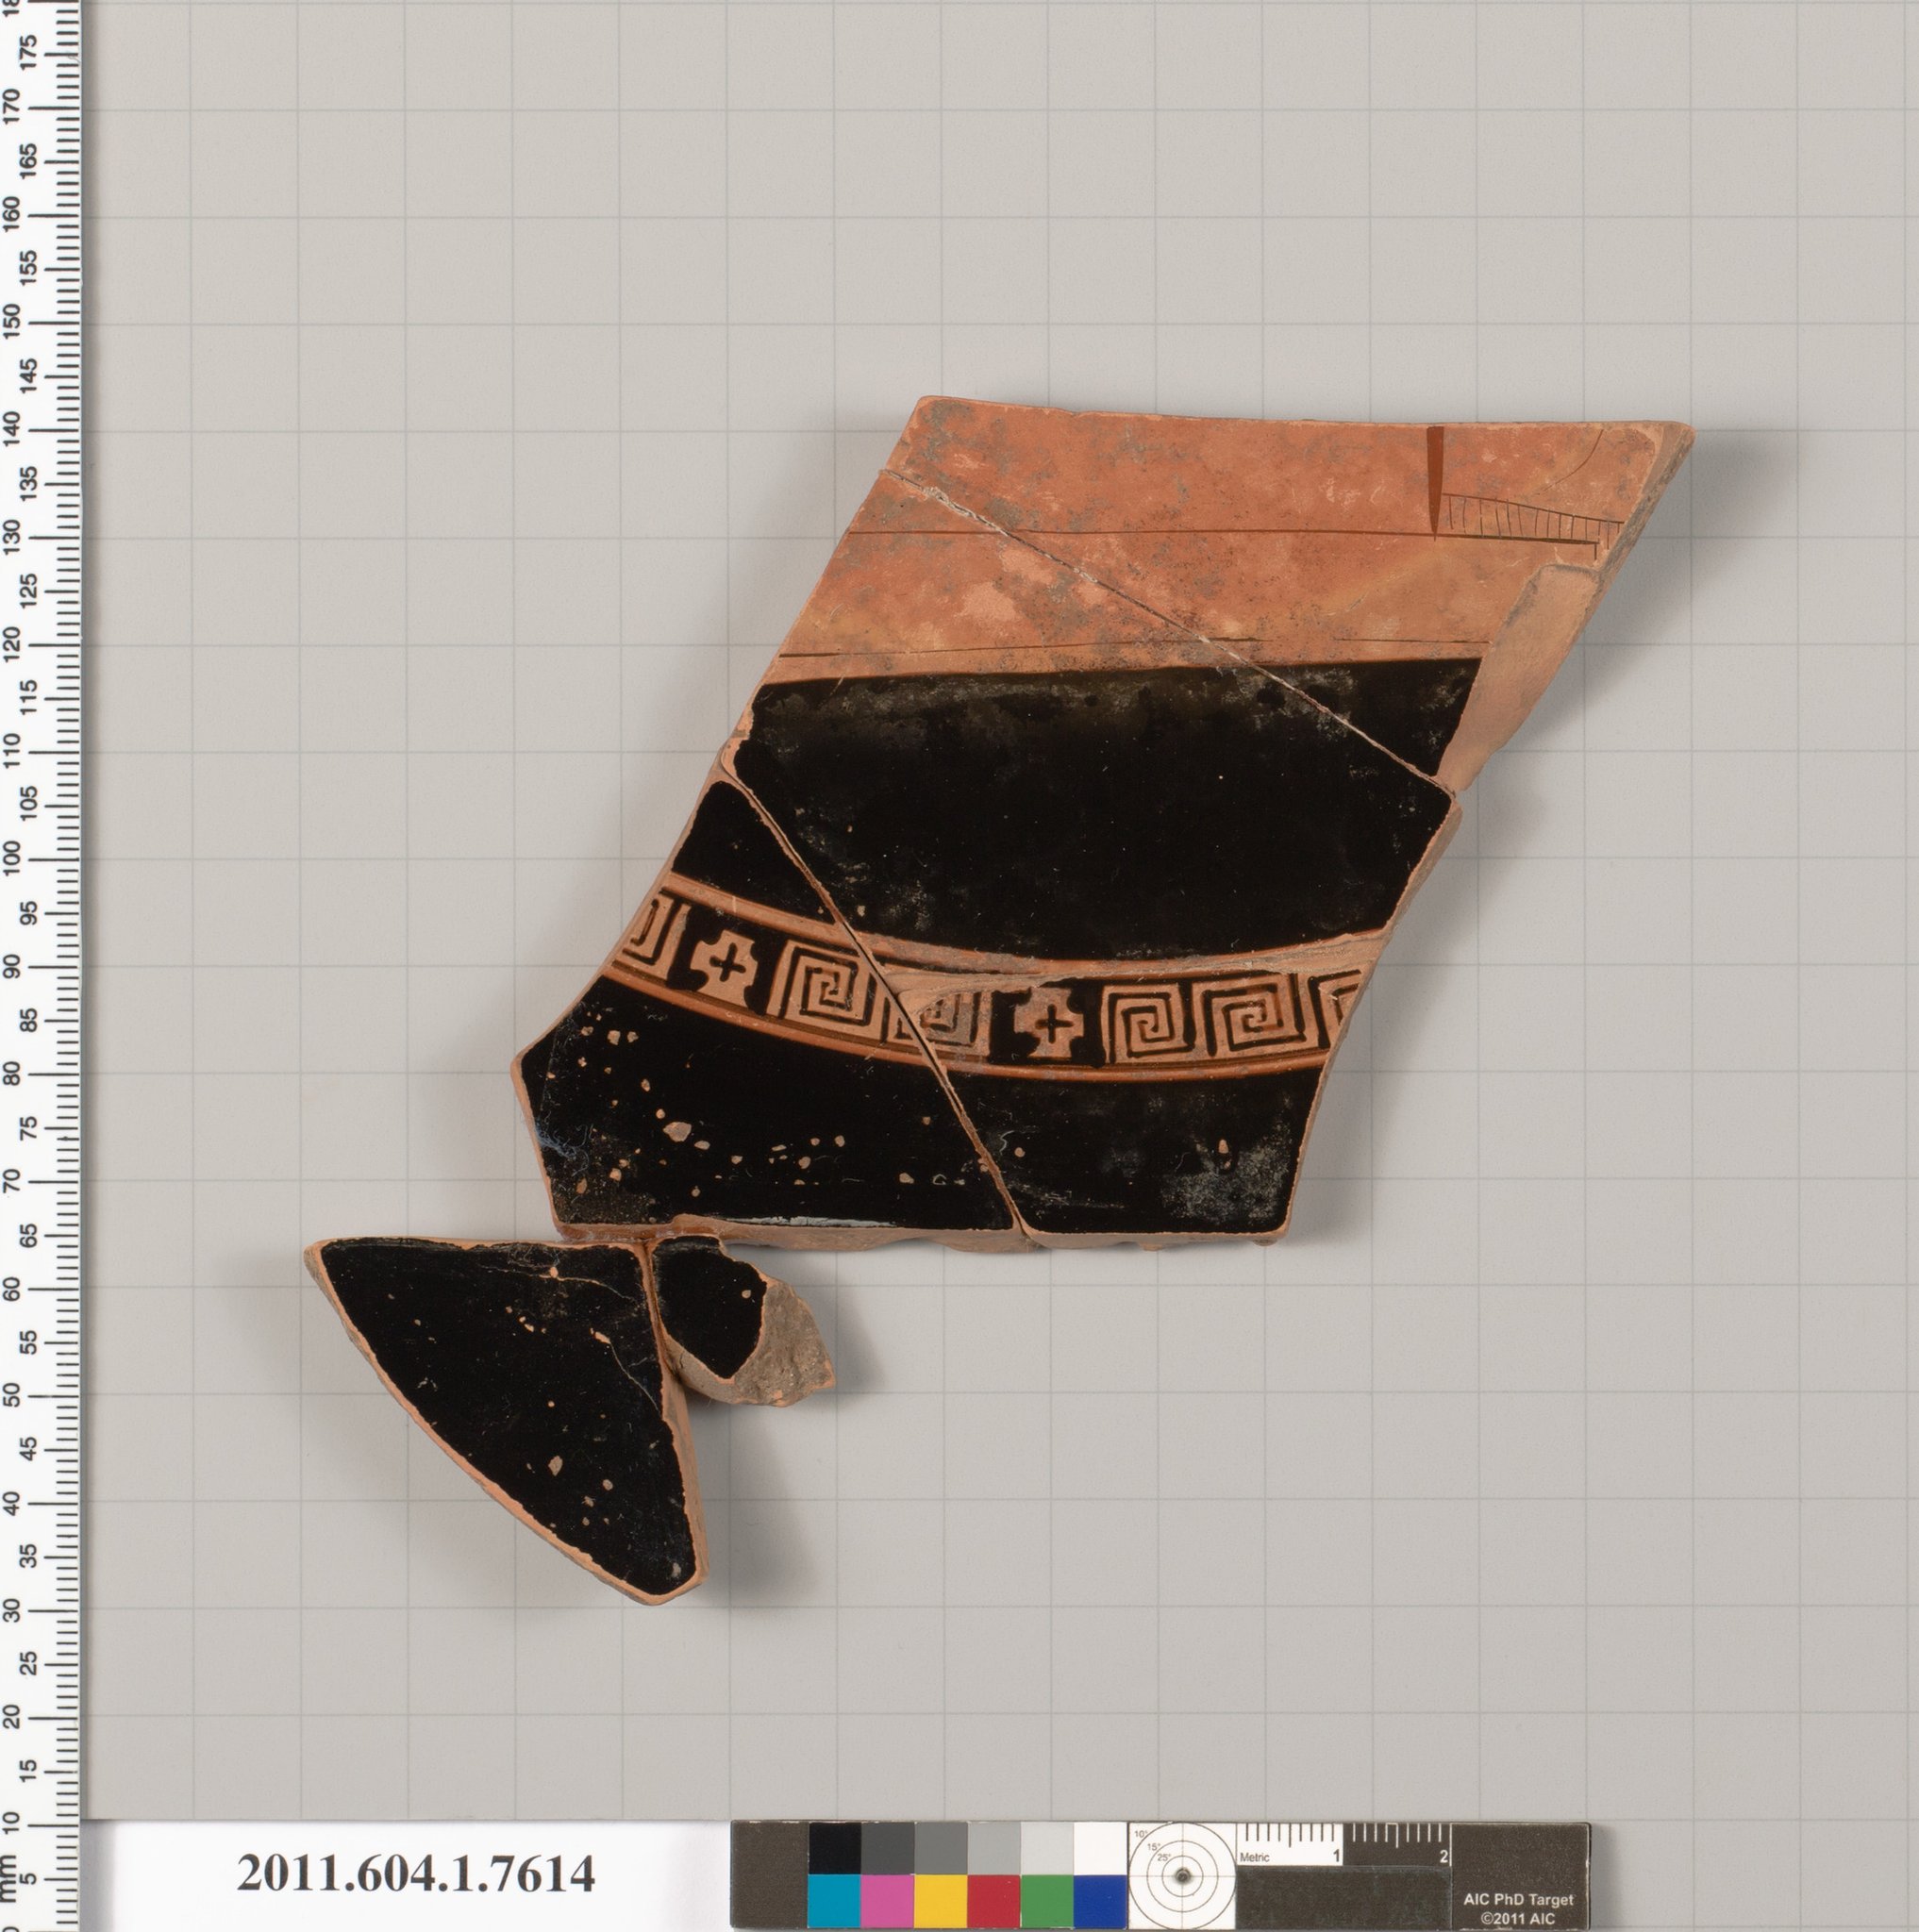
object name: kylix fragment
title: Terracotta fragment of a kylix (drinking cup)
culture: greek, attic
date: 460-450 BCE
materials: terracotta